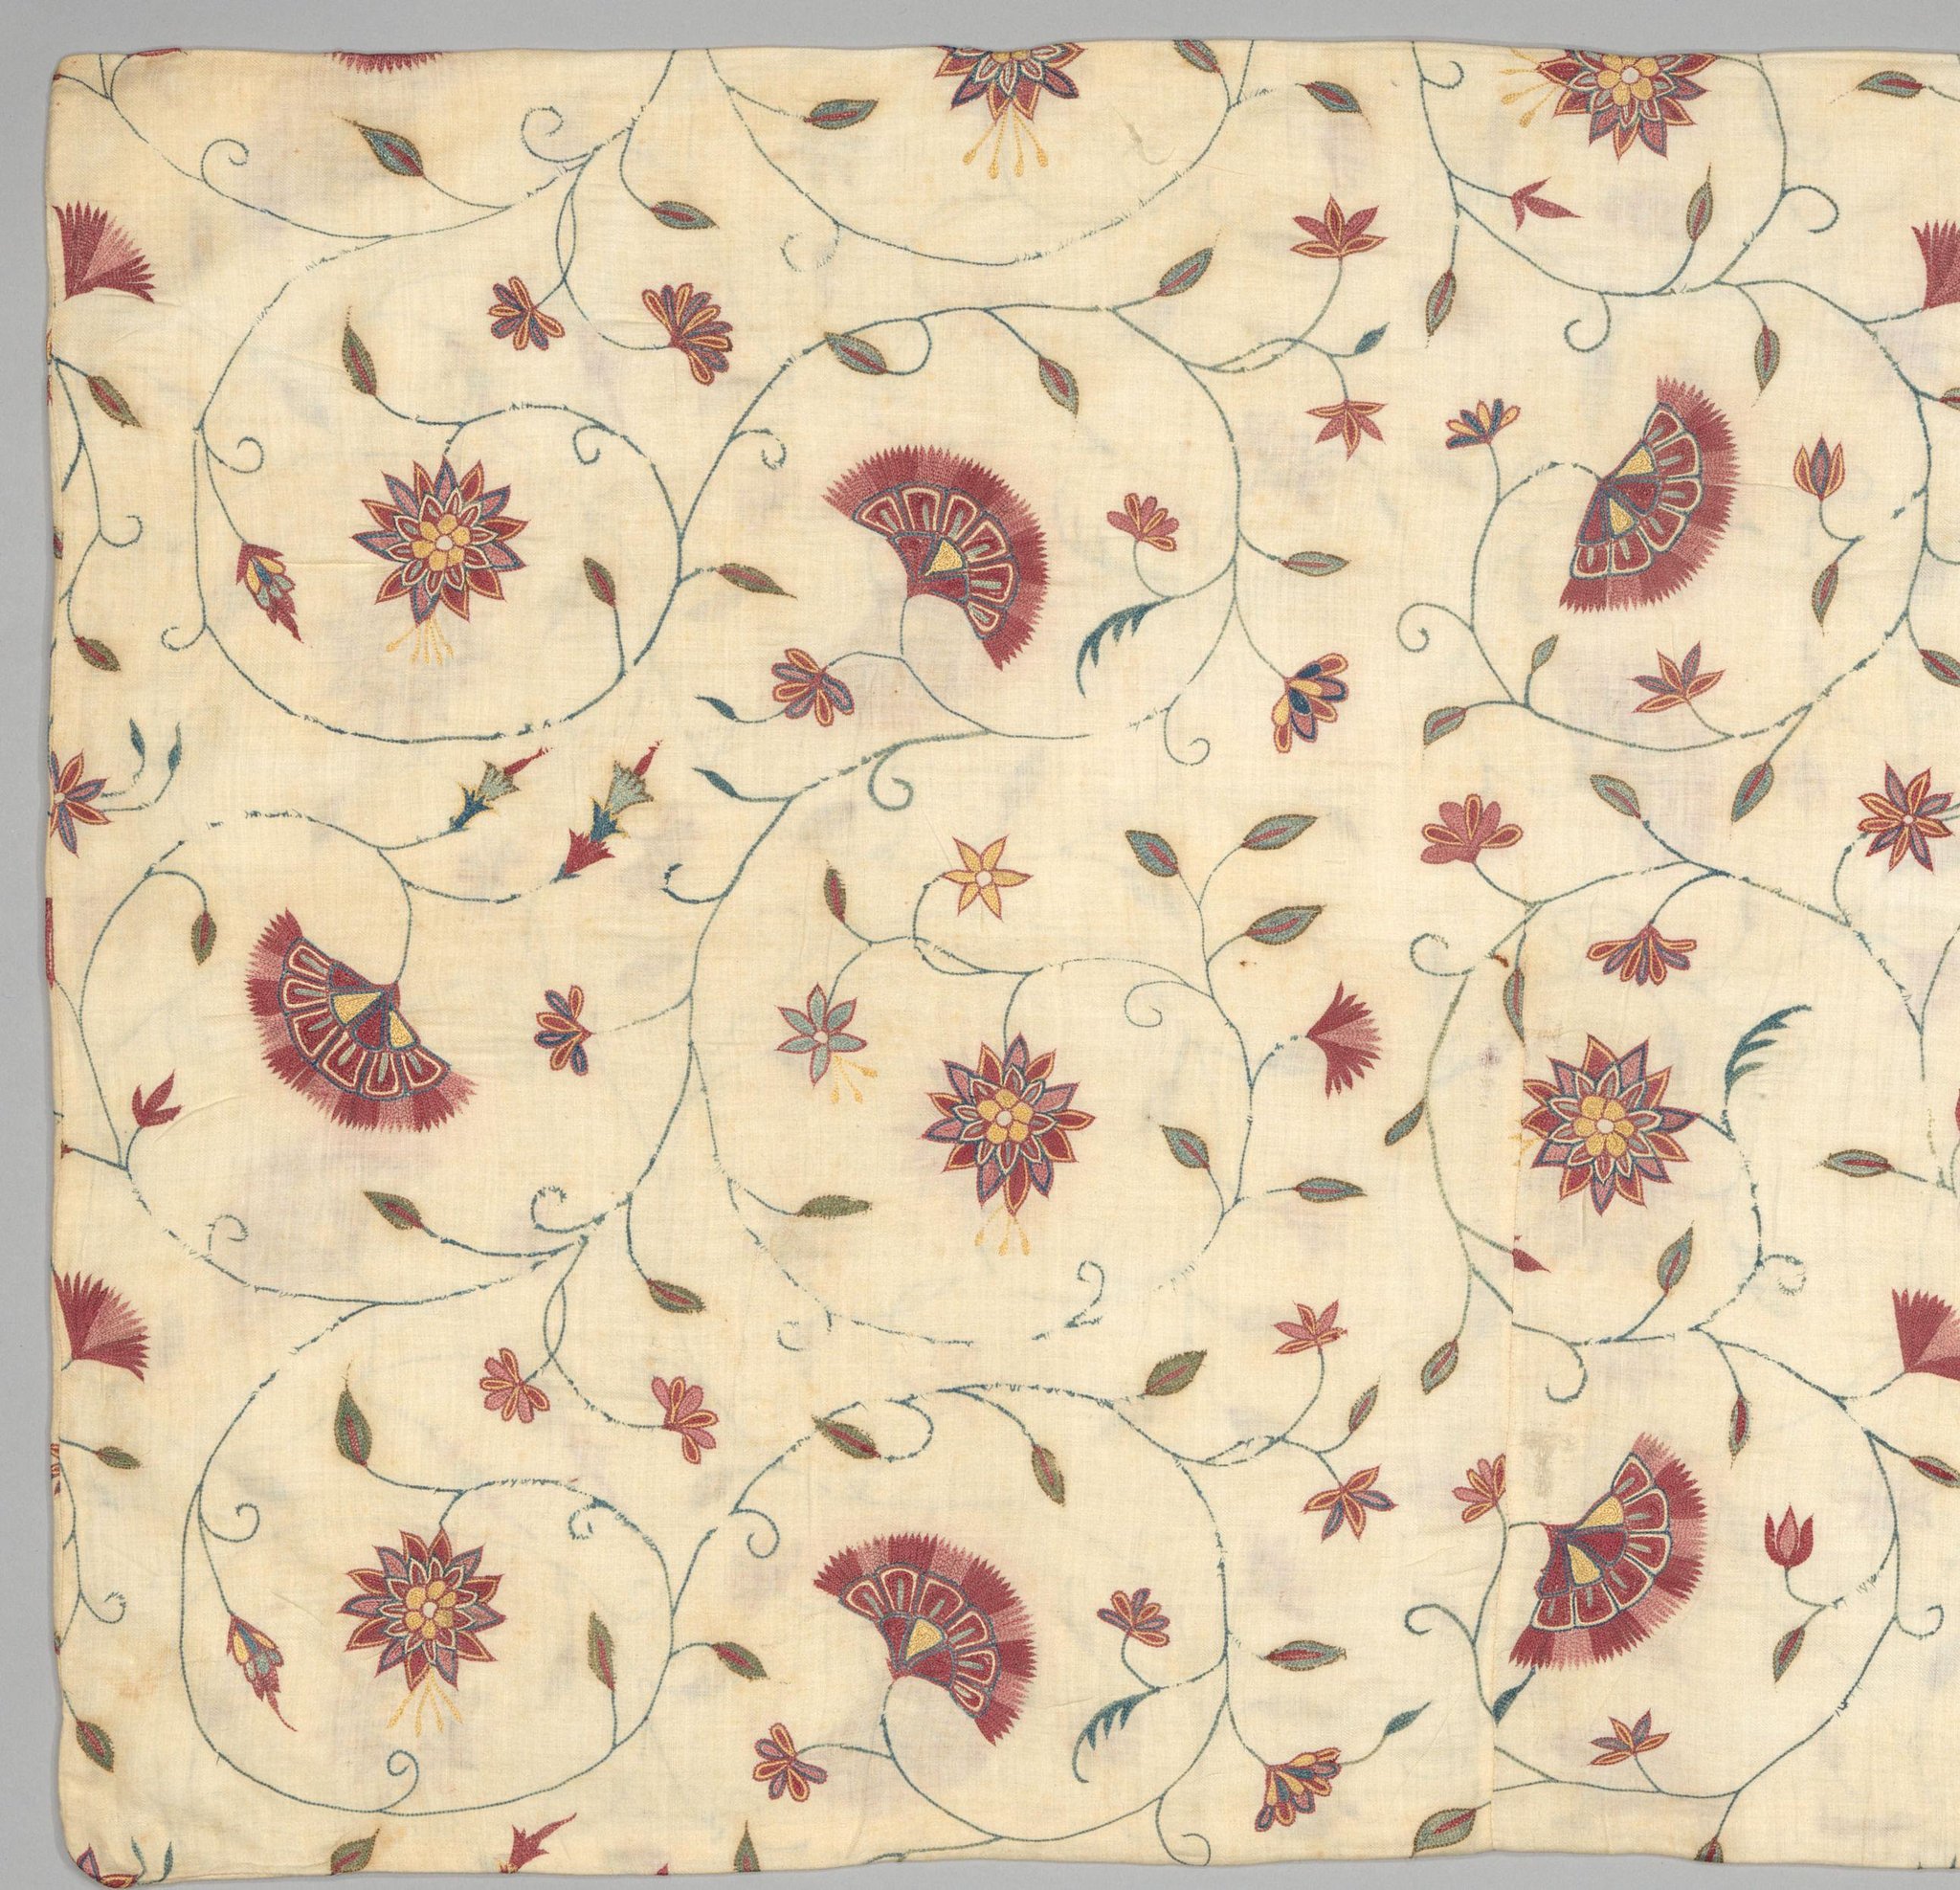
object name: sloop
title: Sloop van gekeperd wit katoen met geborduurde bloemen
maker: Anonymous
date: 1700-1725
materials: cotton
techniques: embroidered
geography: iran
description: Sloop van katoen, met borduurwerk in tamboereertechniek. Het patroon heeft fijne spiraalranken, in rechte rijen geplaatst, met rozet- en waaiervormige bloemen.